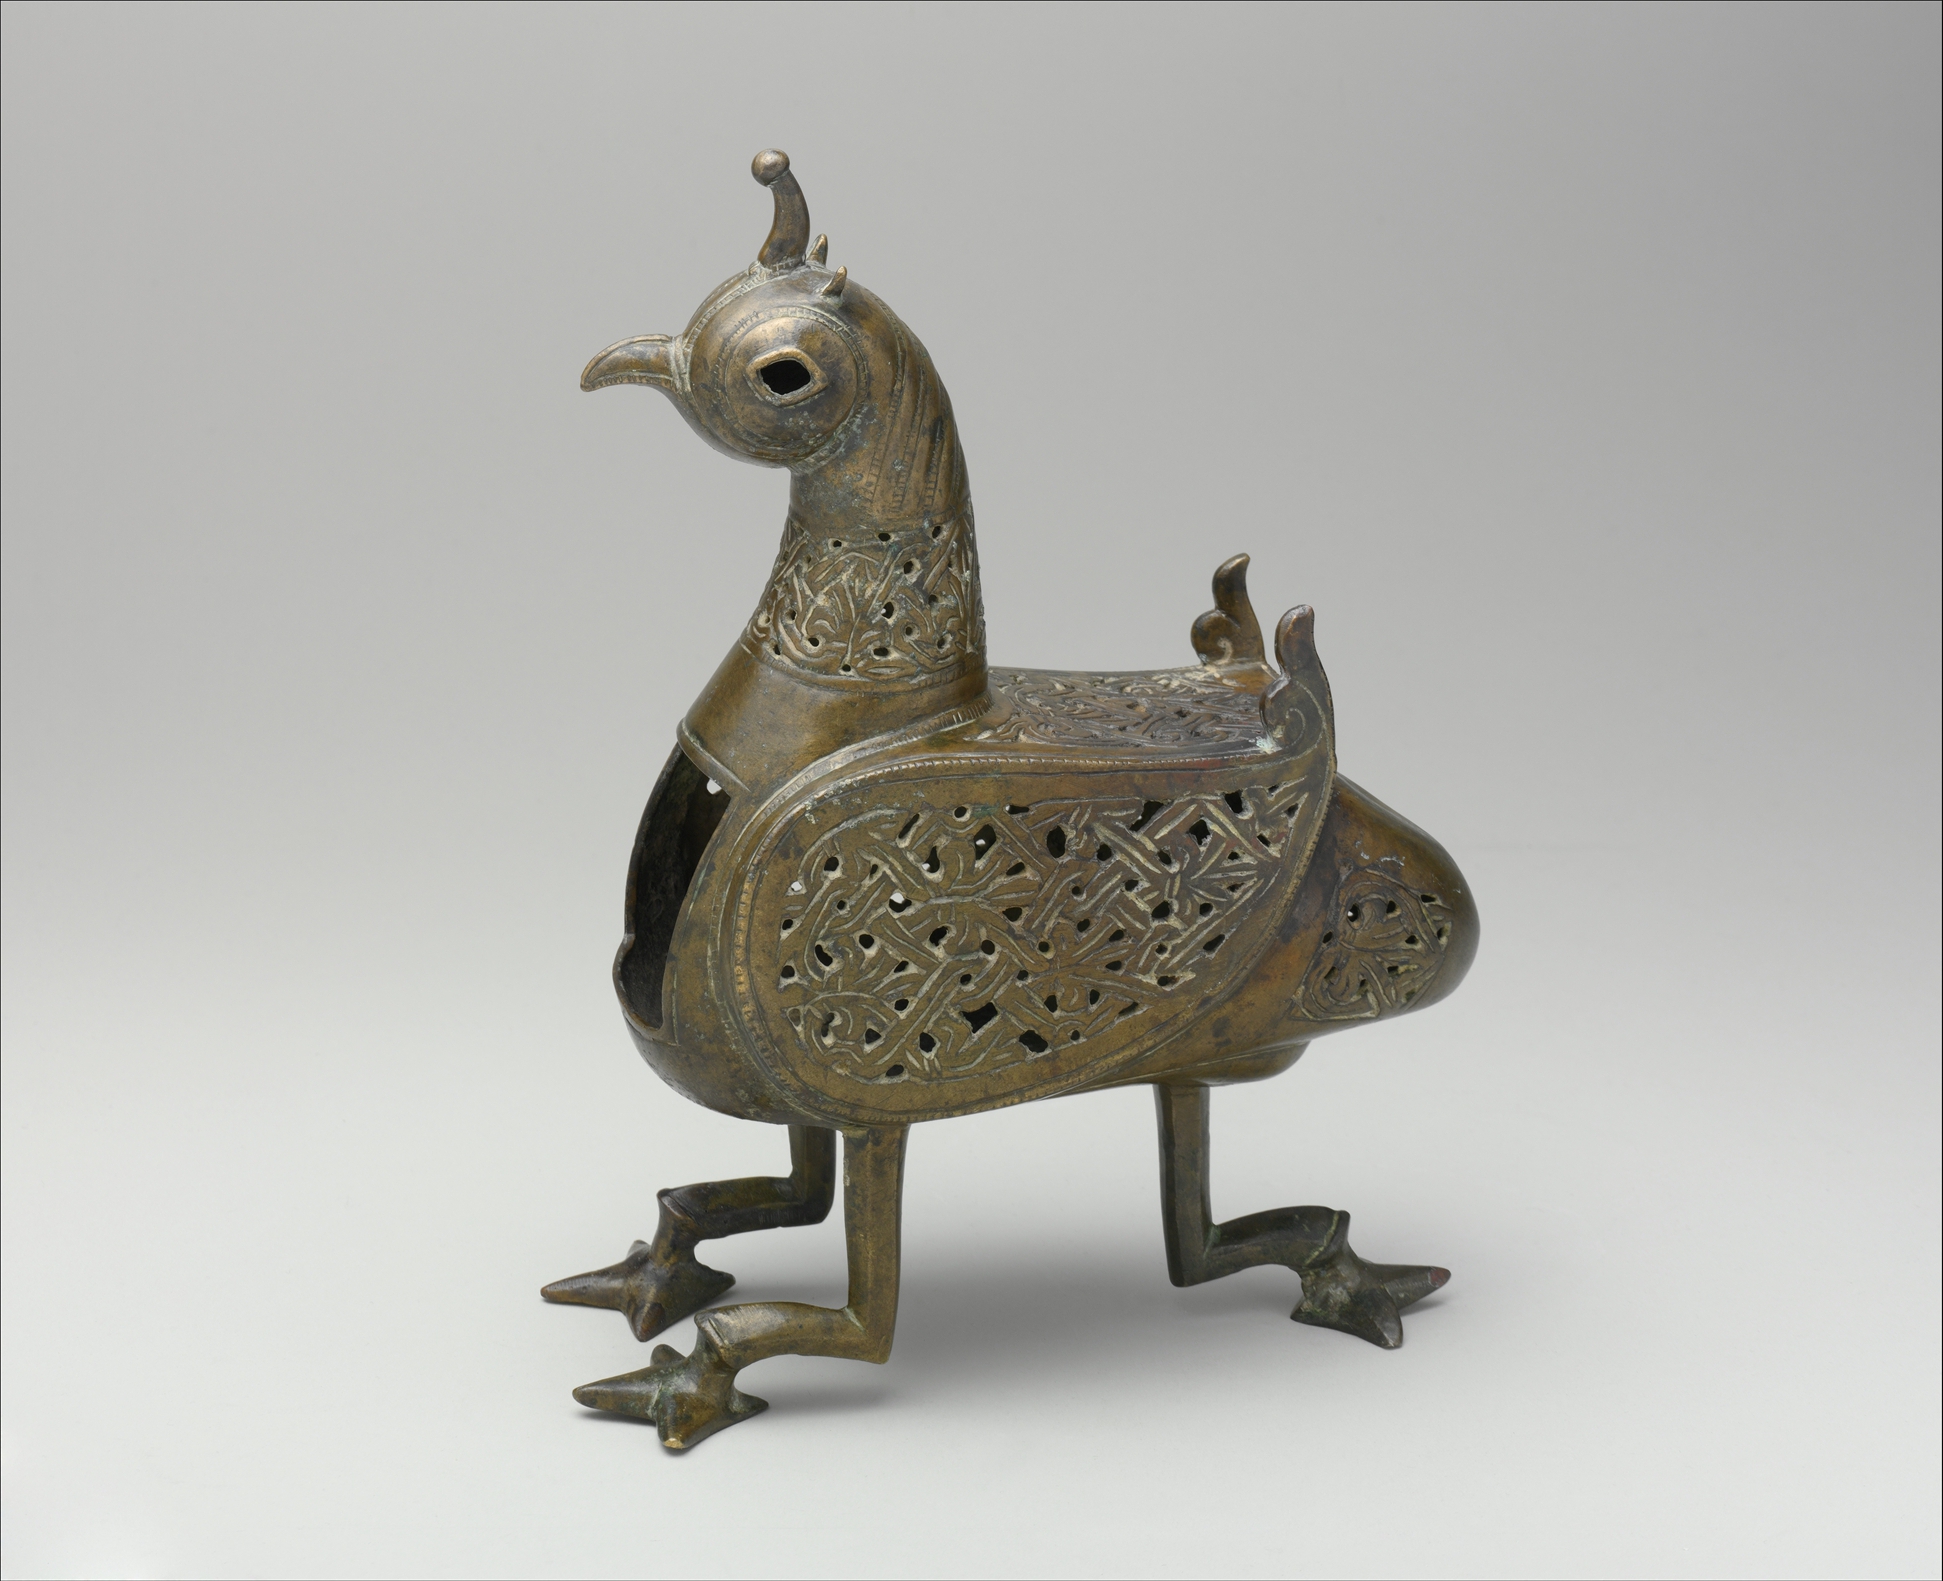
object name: incense burner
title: Bird-Shaped Incence Burner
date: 1101-1300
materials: bronze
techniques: casting, engraving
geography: central asia or eastern iran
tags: birds